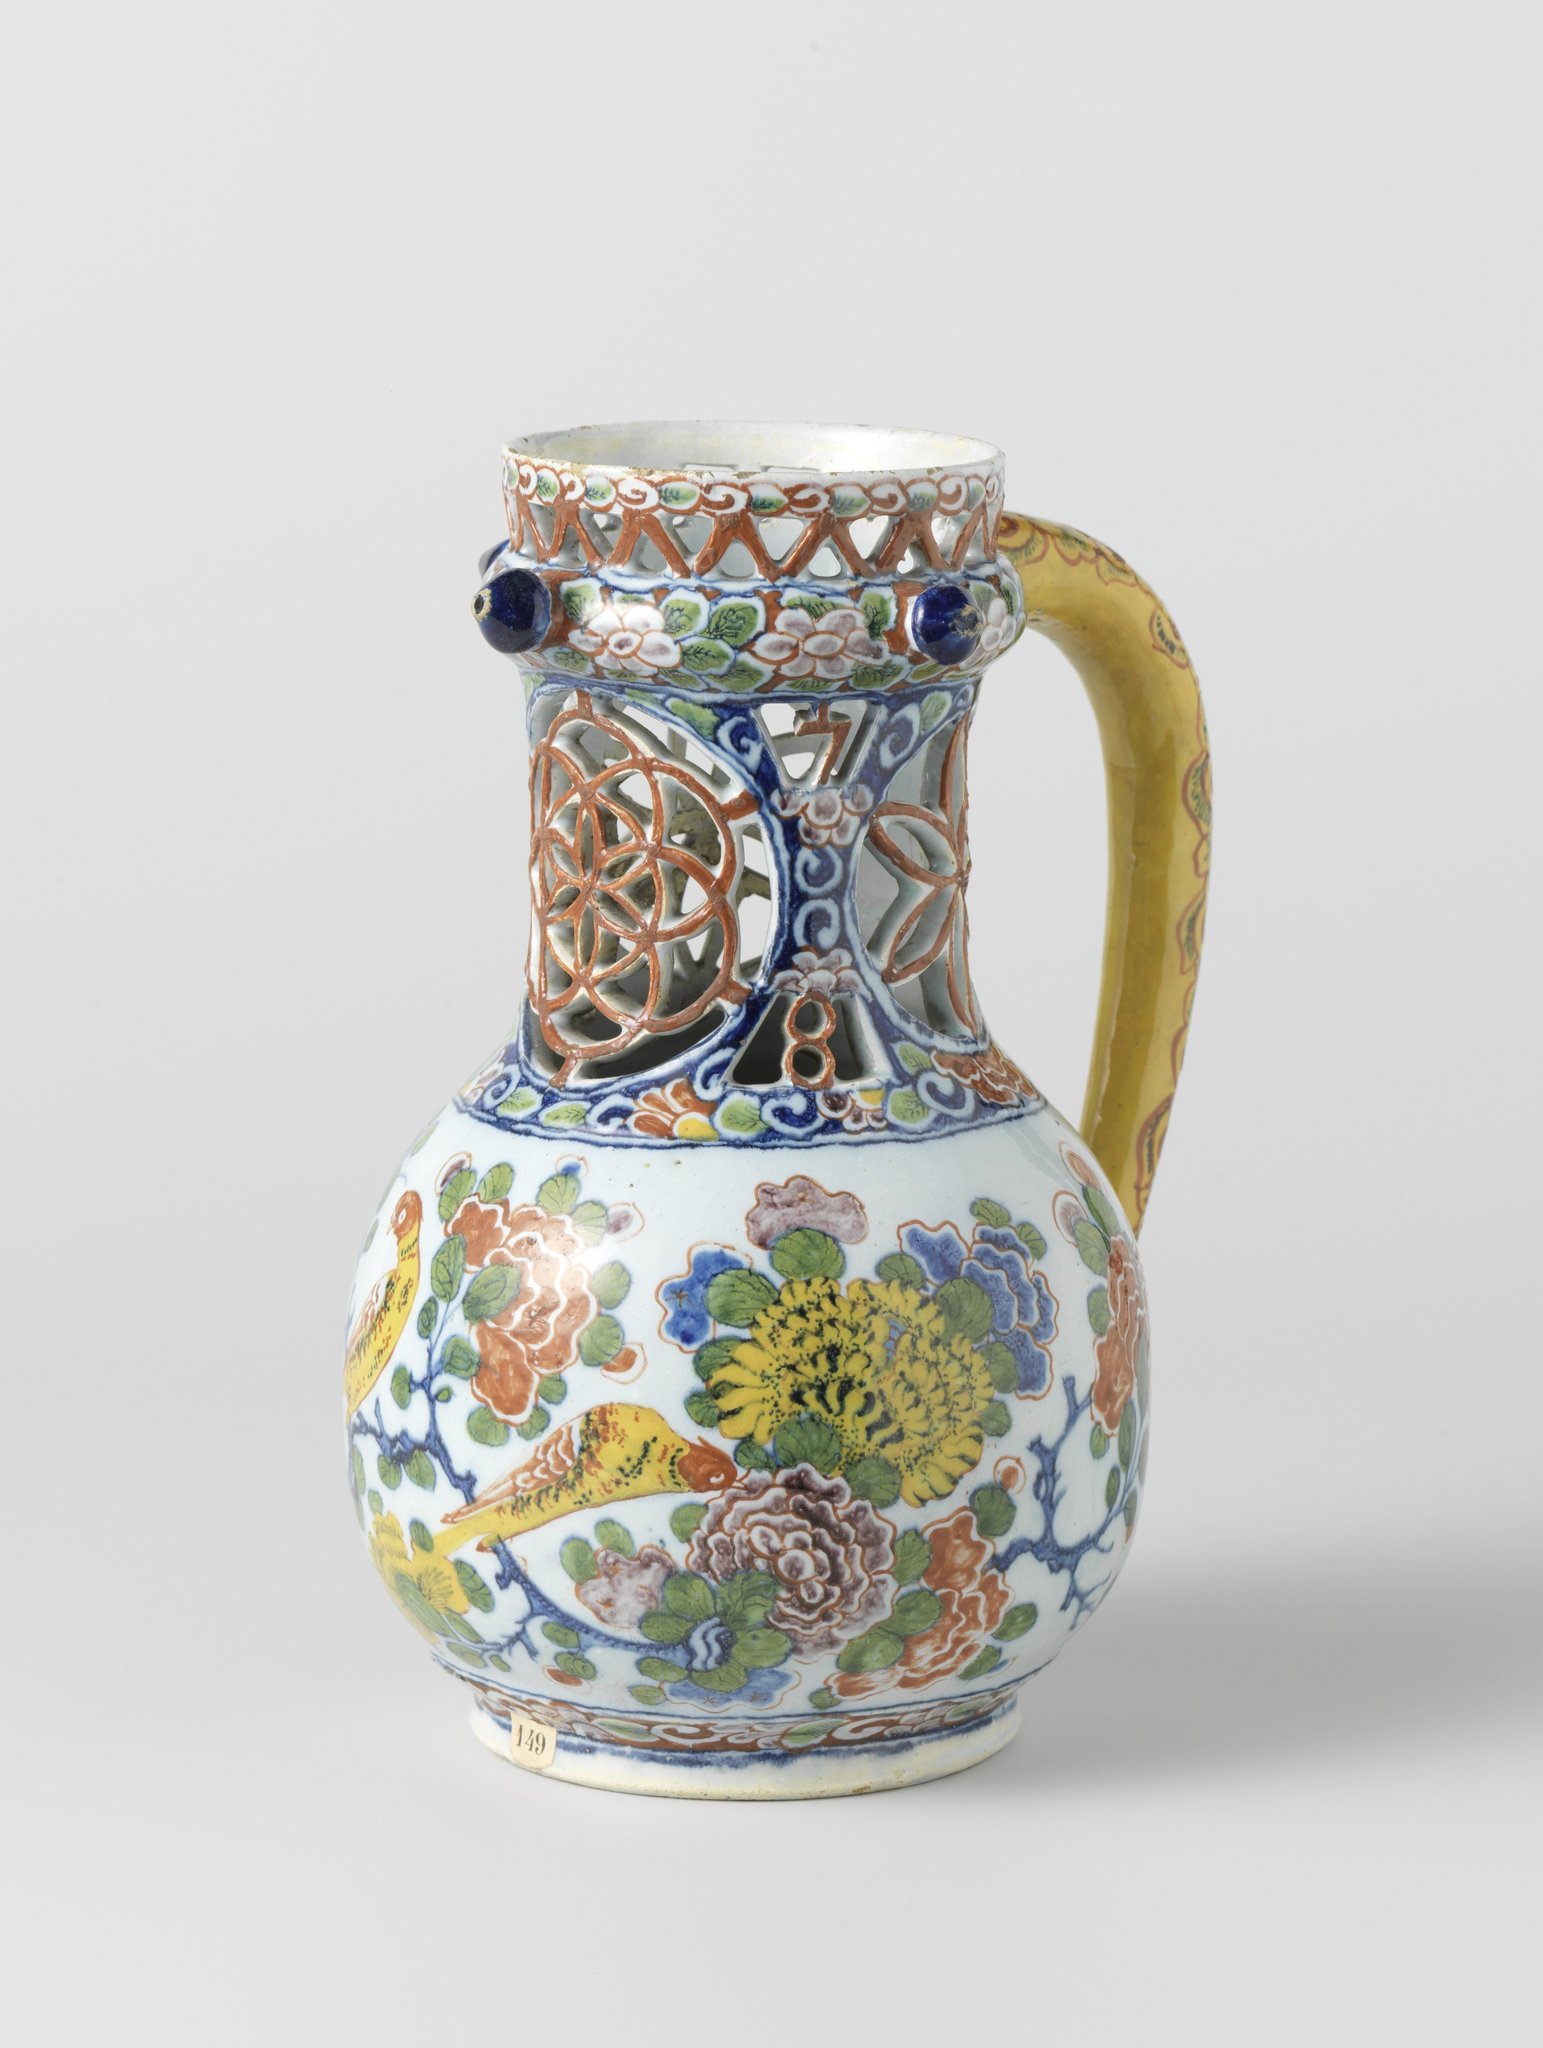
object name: puzzle jug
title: Fopkan, beschilderd met bloemen en vogels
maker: Anonymous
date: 1758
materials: faience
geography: delft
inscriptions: date: ‘1758’, label: ‘149’, collector's mark: ‘collection JF Loudon’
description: Fopkan van faïence, veelkleurig beschilderd met bloemen en vogels.